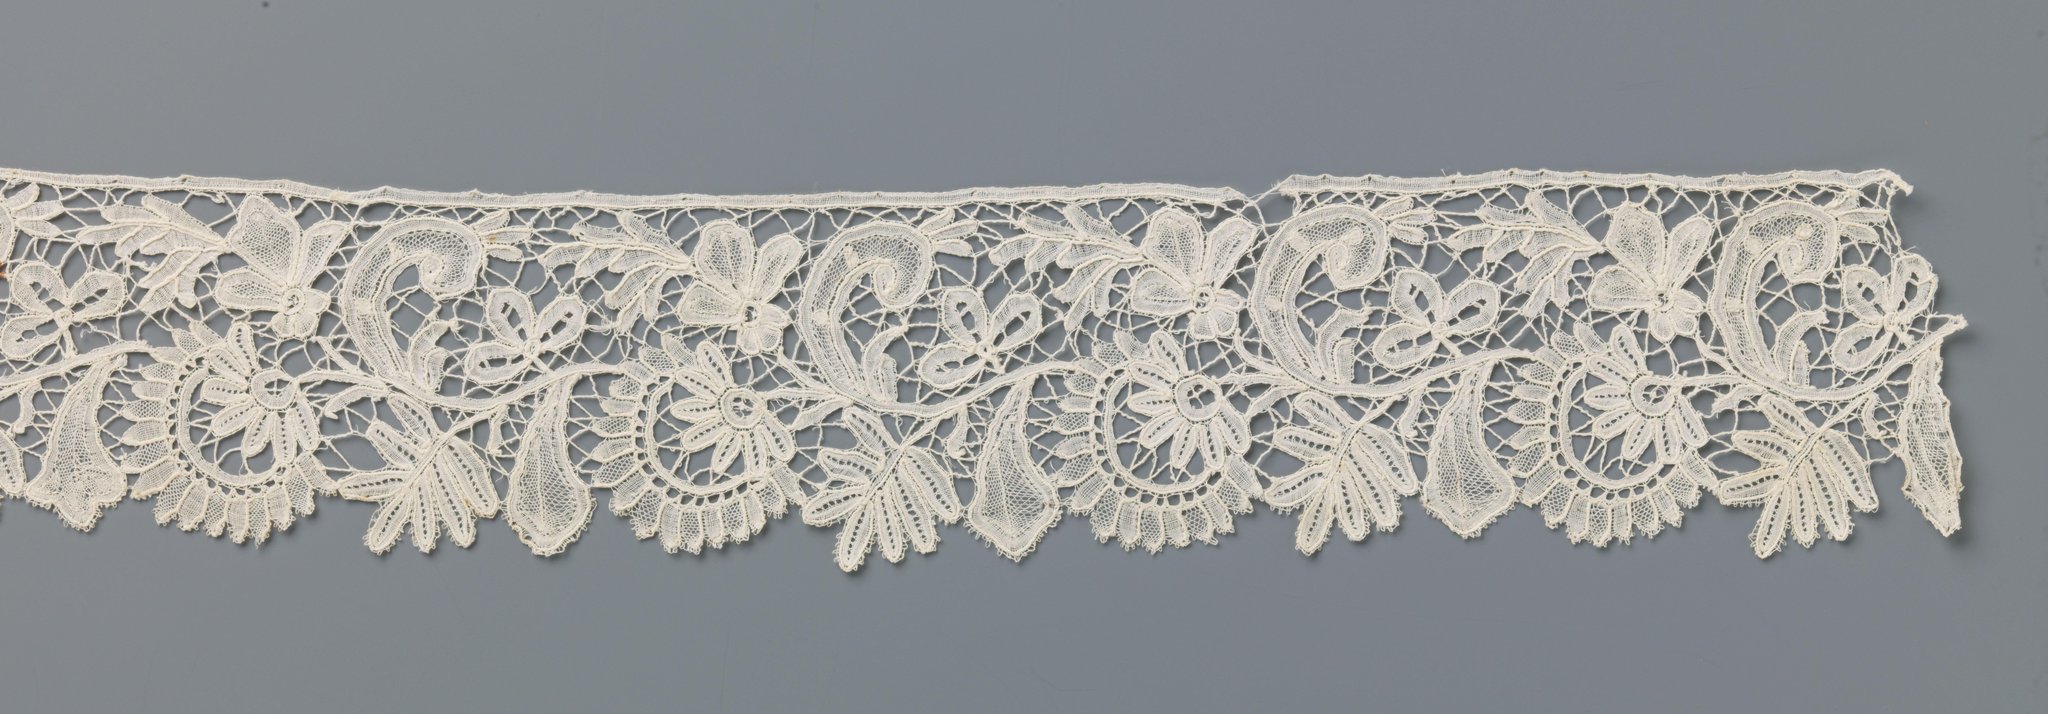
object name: strip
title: Strook kloskant met aster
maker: Anonymous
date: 1900-1924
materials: linen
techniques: lace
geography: netherlands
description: Strook naturelkleurige kloskant: duchesse-kant. Op een open vlechtengrond staat een eenzijdig gerichte lopende rank, die naar binnen eindigt in een brede spiraalrank en naar buiten in een en profil geziene aster.